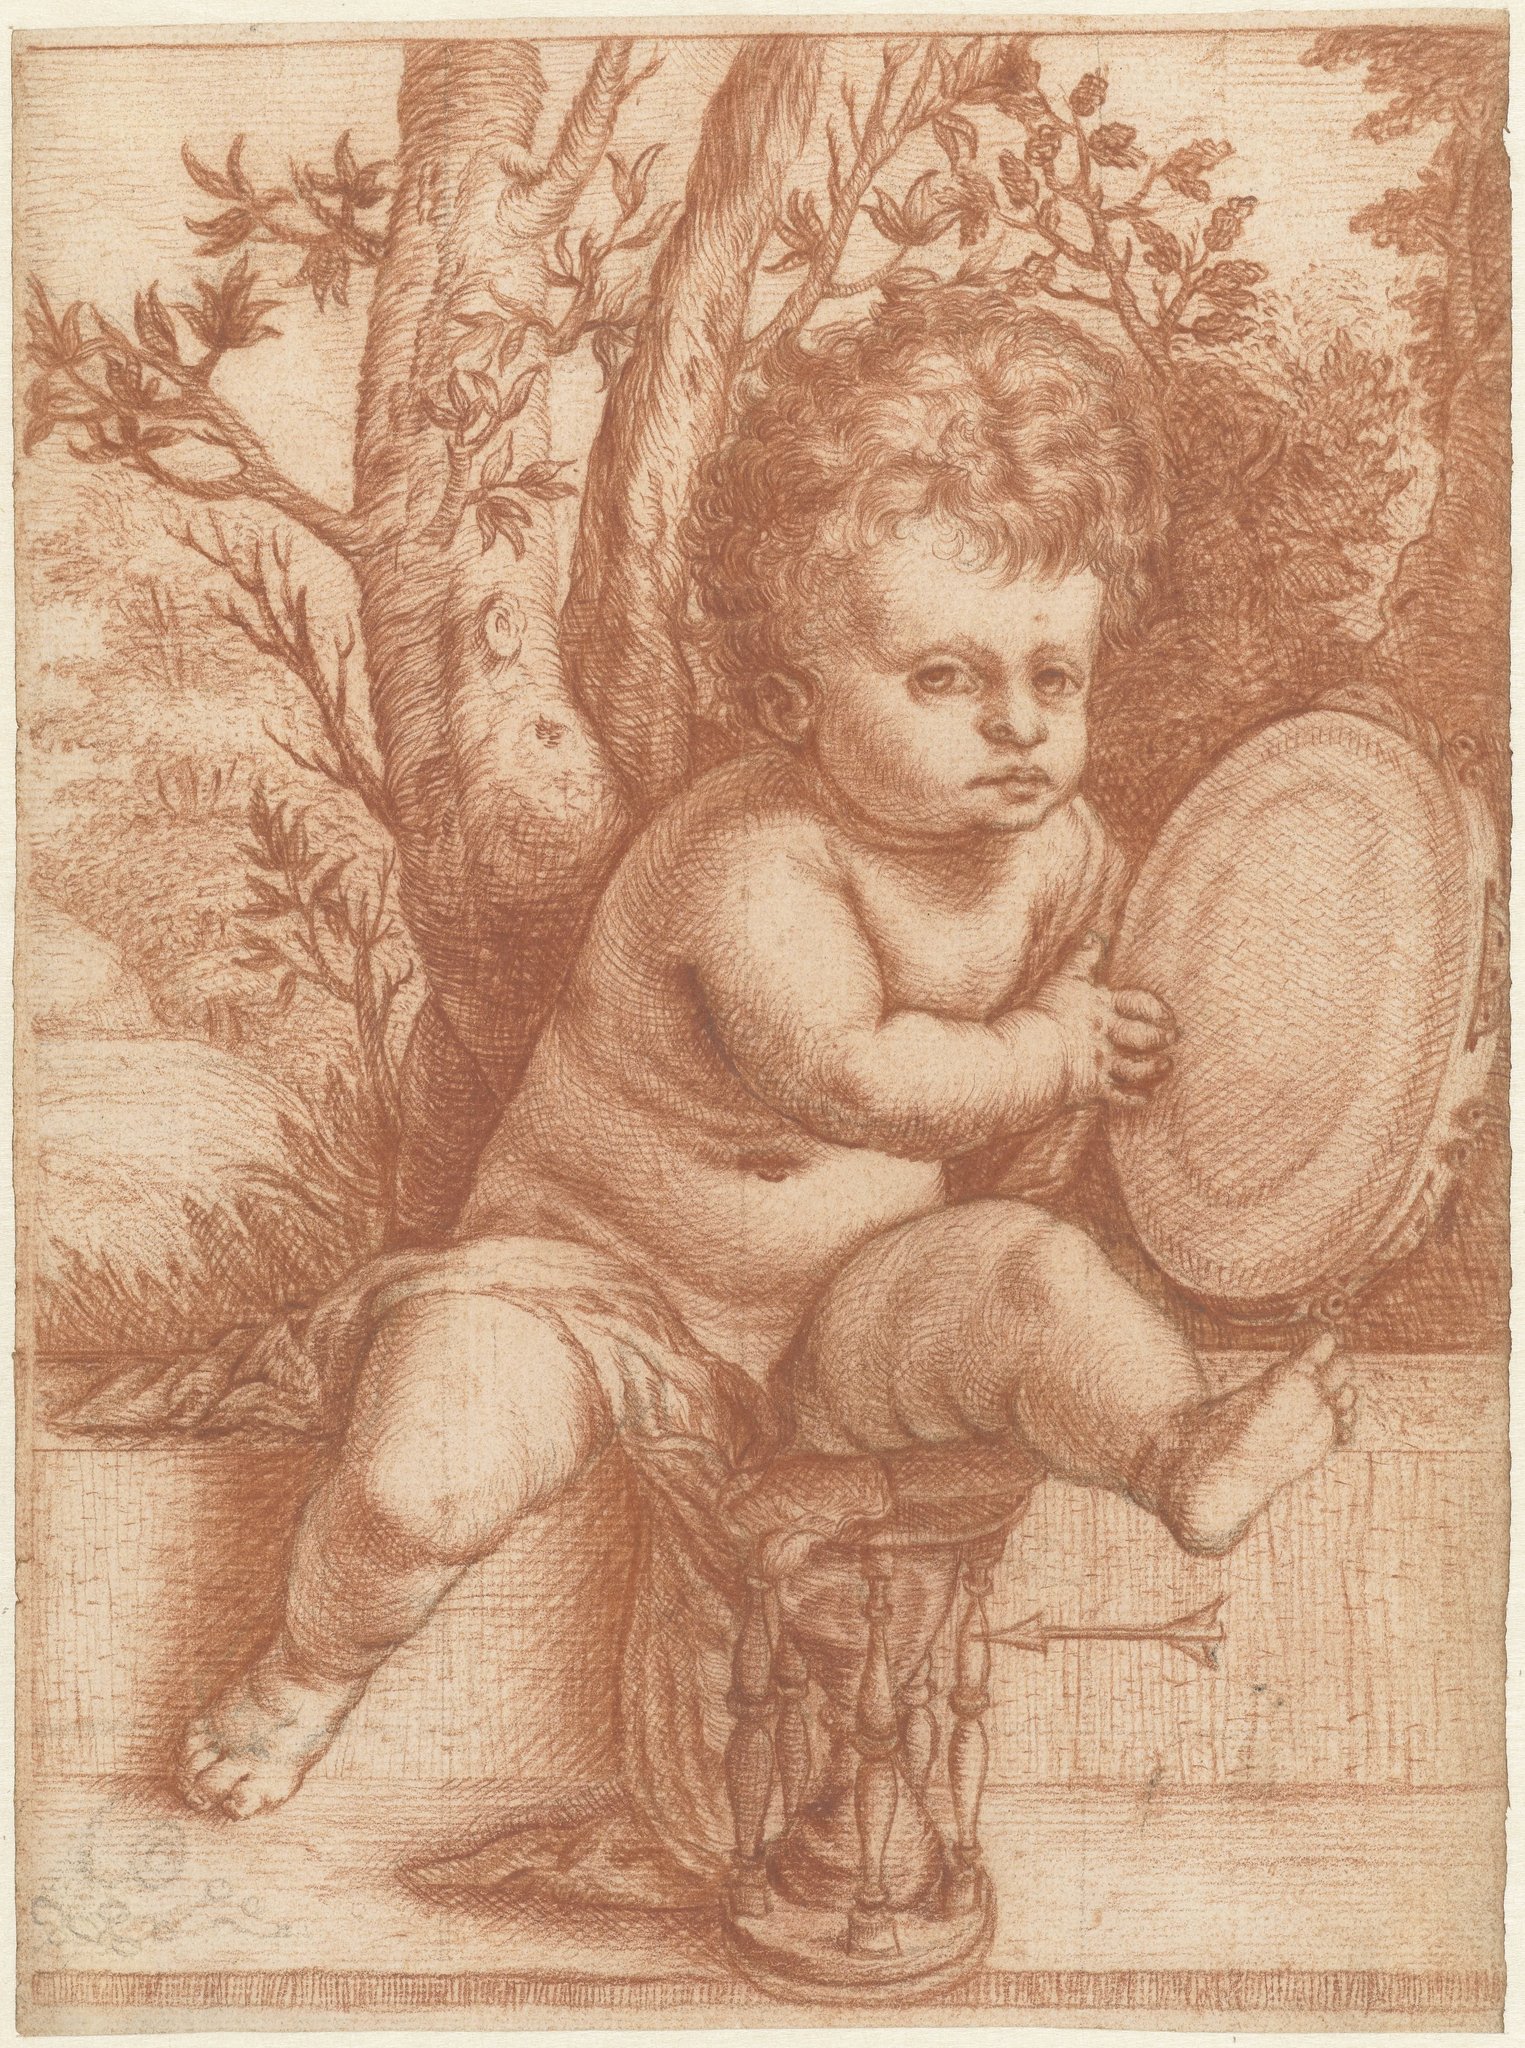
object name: drawing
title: Jongetje met tamboerijn en zandloper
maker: jordanus hoorn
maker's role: draughtsman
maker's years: 1753-1833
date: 1763-1833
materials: chalk, paper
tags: scenes symbolizing 'vanitas', tambourine, one person playing percussion instrument, toddler (male), hourglass